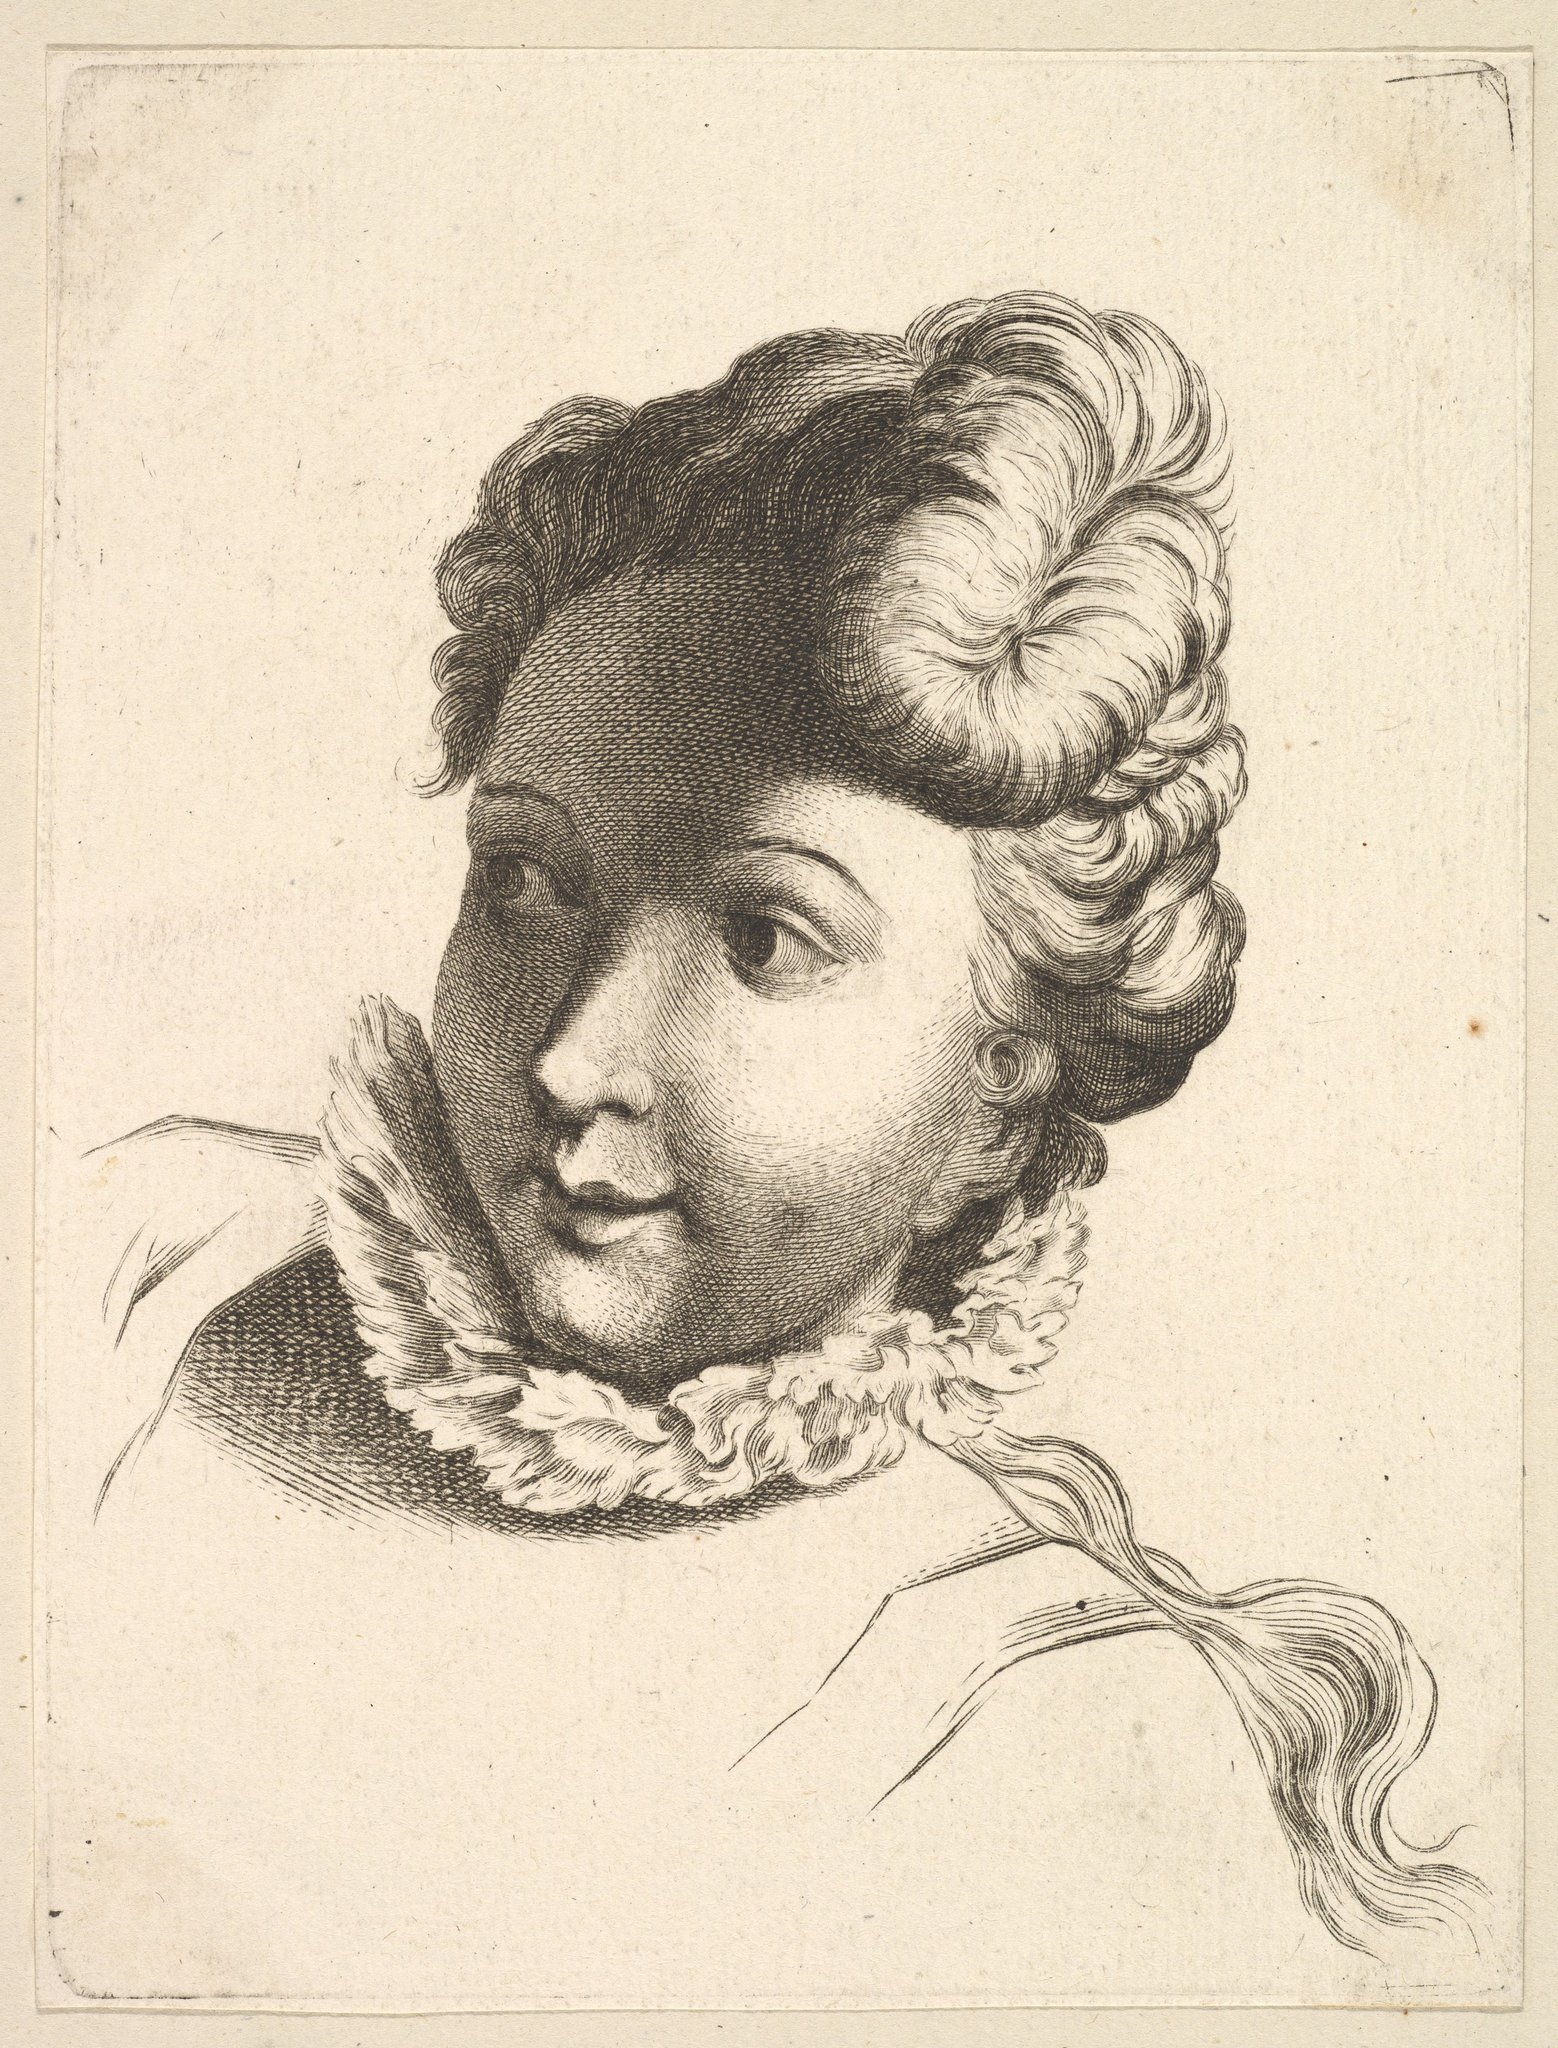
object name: print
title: Head of a Woman Wearing a Ruff, from "Livre de Têtes Gravées d'apres F. Boucher et Autres" (Book of Heads Engraved after F. Boucher and Others)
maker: anonymous, french, 18th century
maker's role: artist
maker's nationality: french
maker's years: 1700-1800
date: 1701-1800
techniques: engraving, etching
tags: heads,women